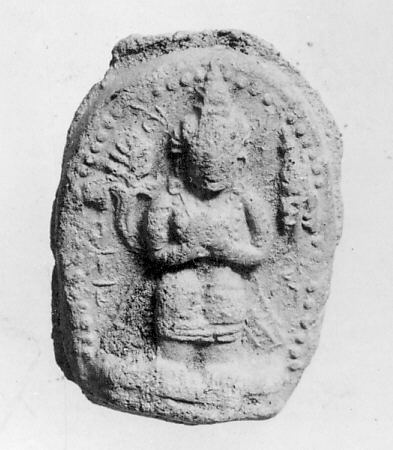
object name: plaque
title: Votive Plaque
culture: central asian or tibetan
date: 1401-1700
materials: clay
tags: human figures